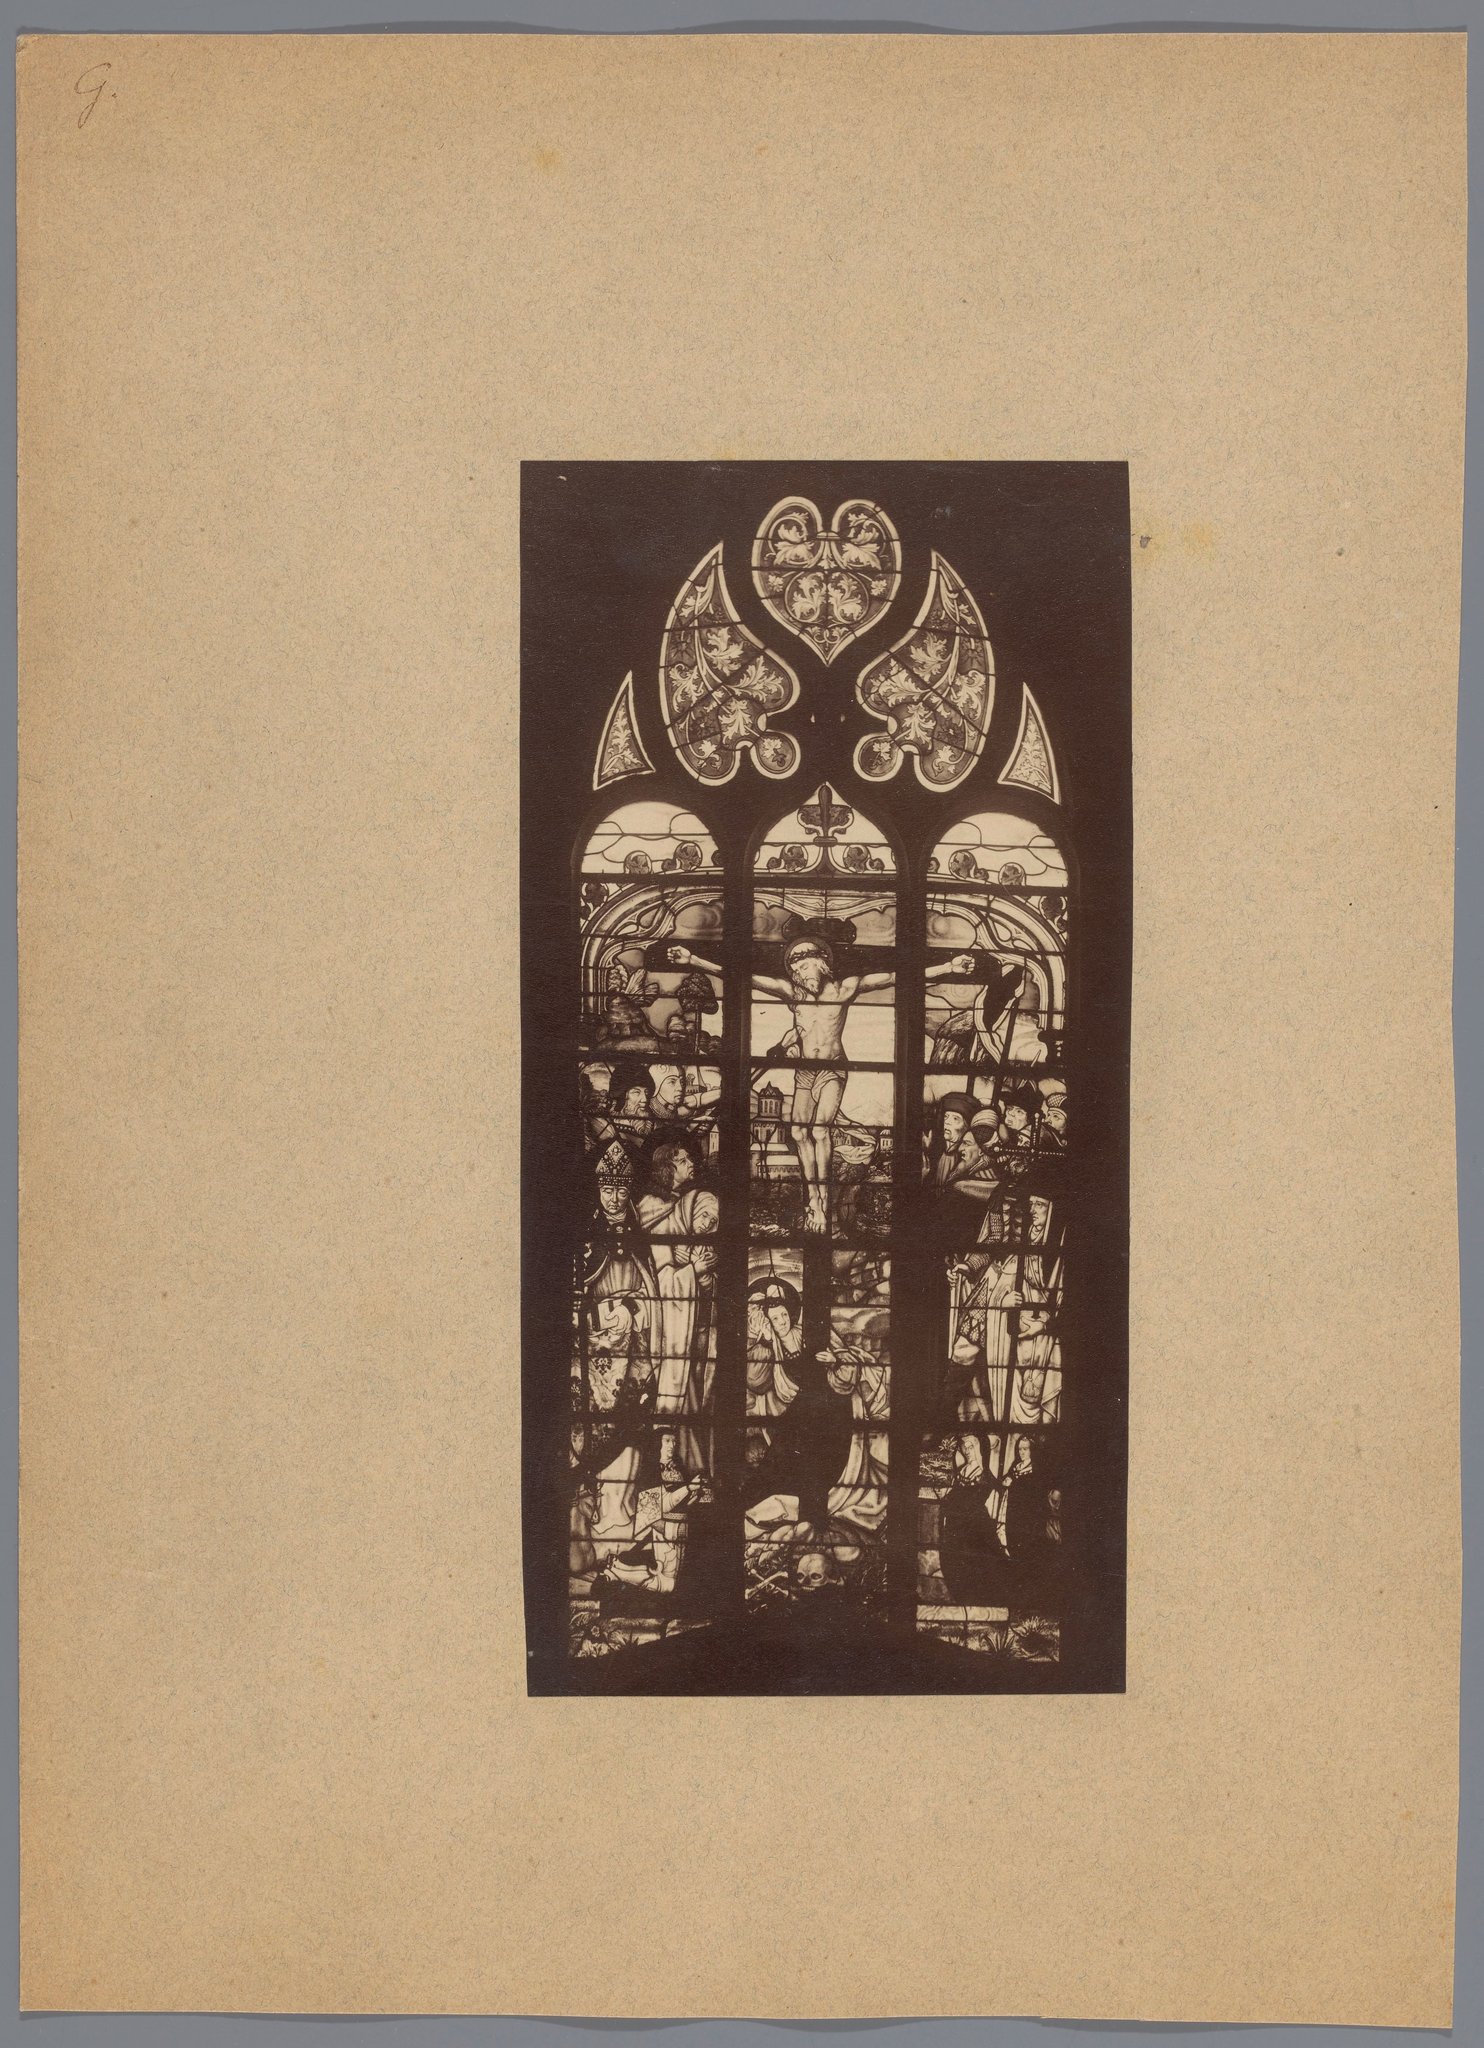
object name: photograph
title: Glas-in-loodraam met Christus aan het kruis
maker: Anonymous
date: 1875-1900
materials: cardboard, photographic support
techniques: albumen print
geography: europe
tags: adoration of the kings: the wise men present their gifts to the christ-child (gold, frankincense and myrrh), bystanders at the foot of the cross, among whom mary, mary magdalene and john the evangelist; mary may be shown swooning, christ is nailed to the erected cross - dd - three crosses, europe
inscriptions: inscription: ‘us aan het Kruis’, collector's mark: ‘RIJKS-NORMAALSCHOOL-VOOR-TEEKENONDERWIJZERS-AMSTERDAM’